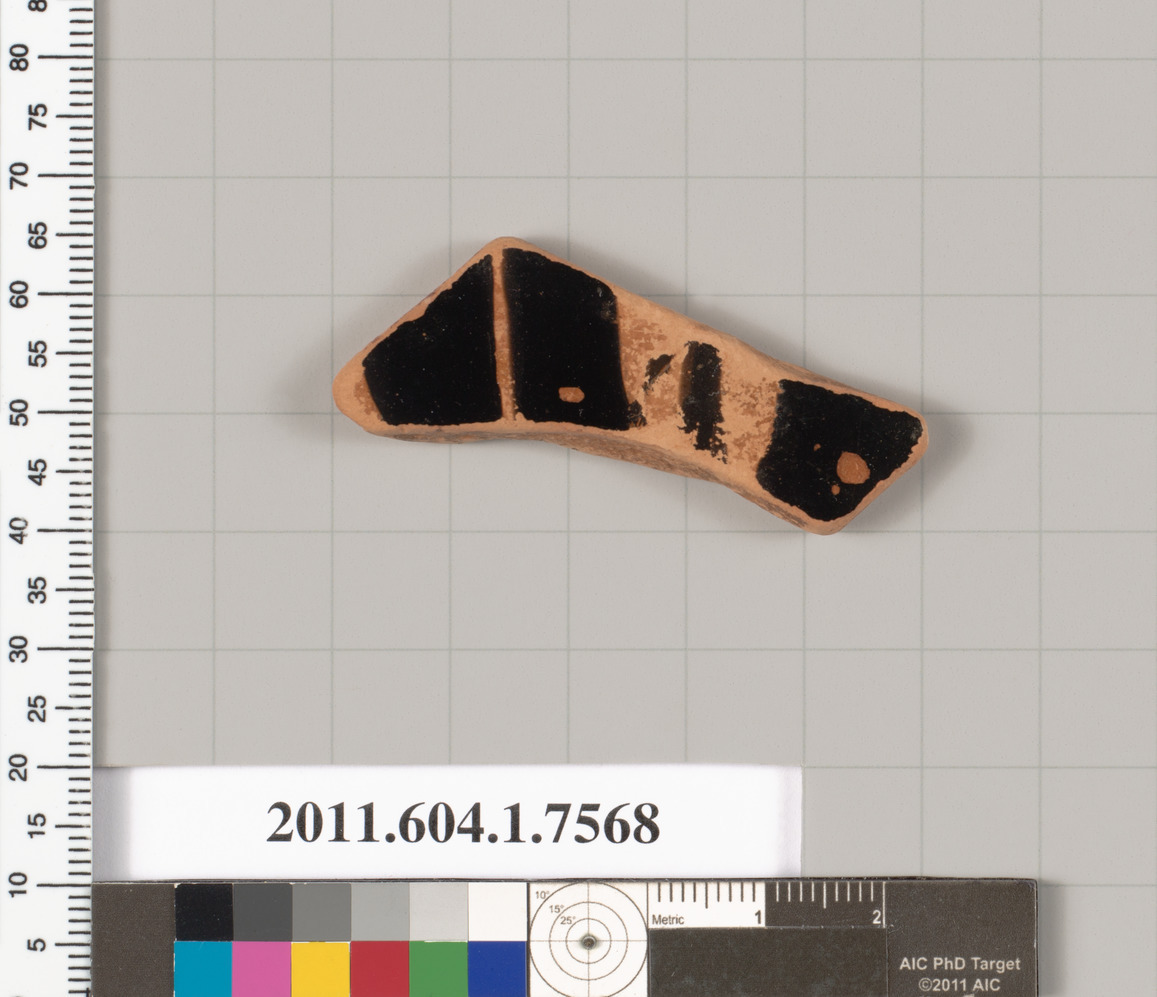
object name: kylix fragment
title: Terracotta fragment of a kylix (drinking cup)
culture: greek, attic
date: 460-450 BCE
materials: terracotta